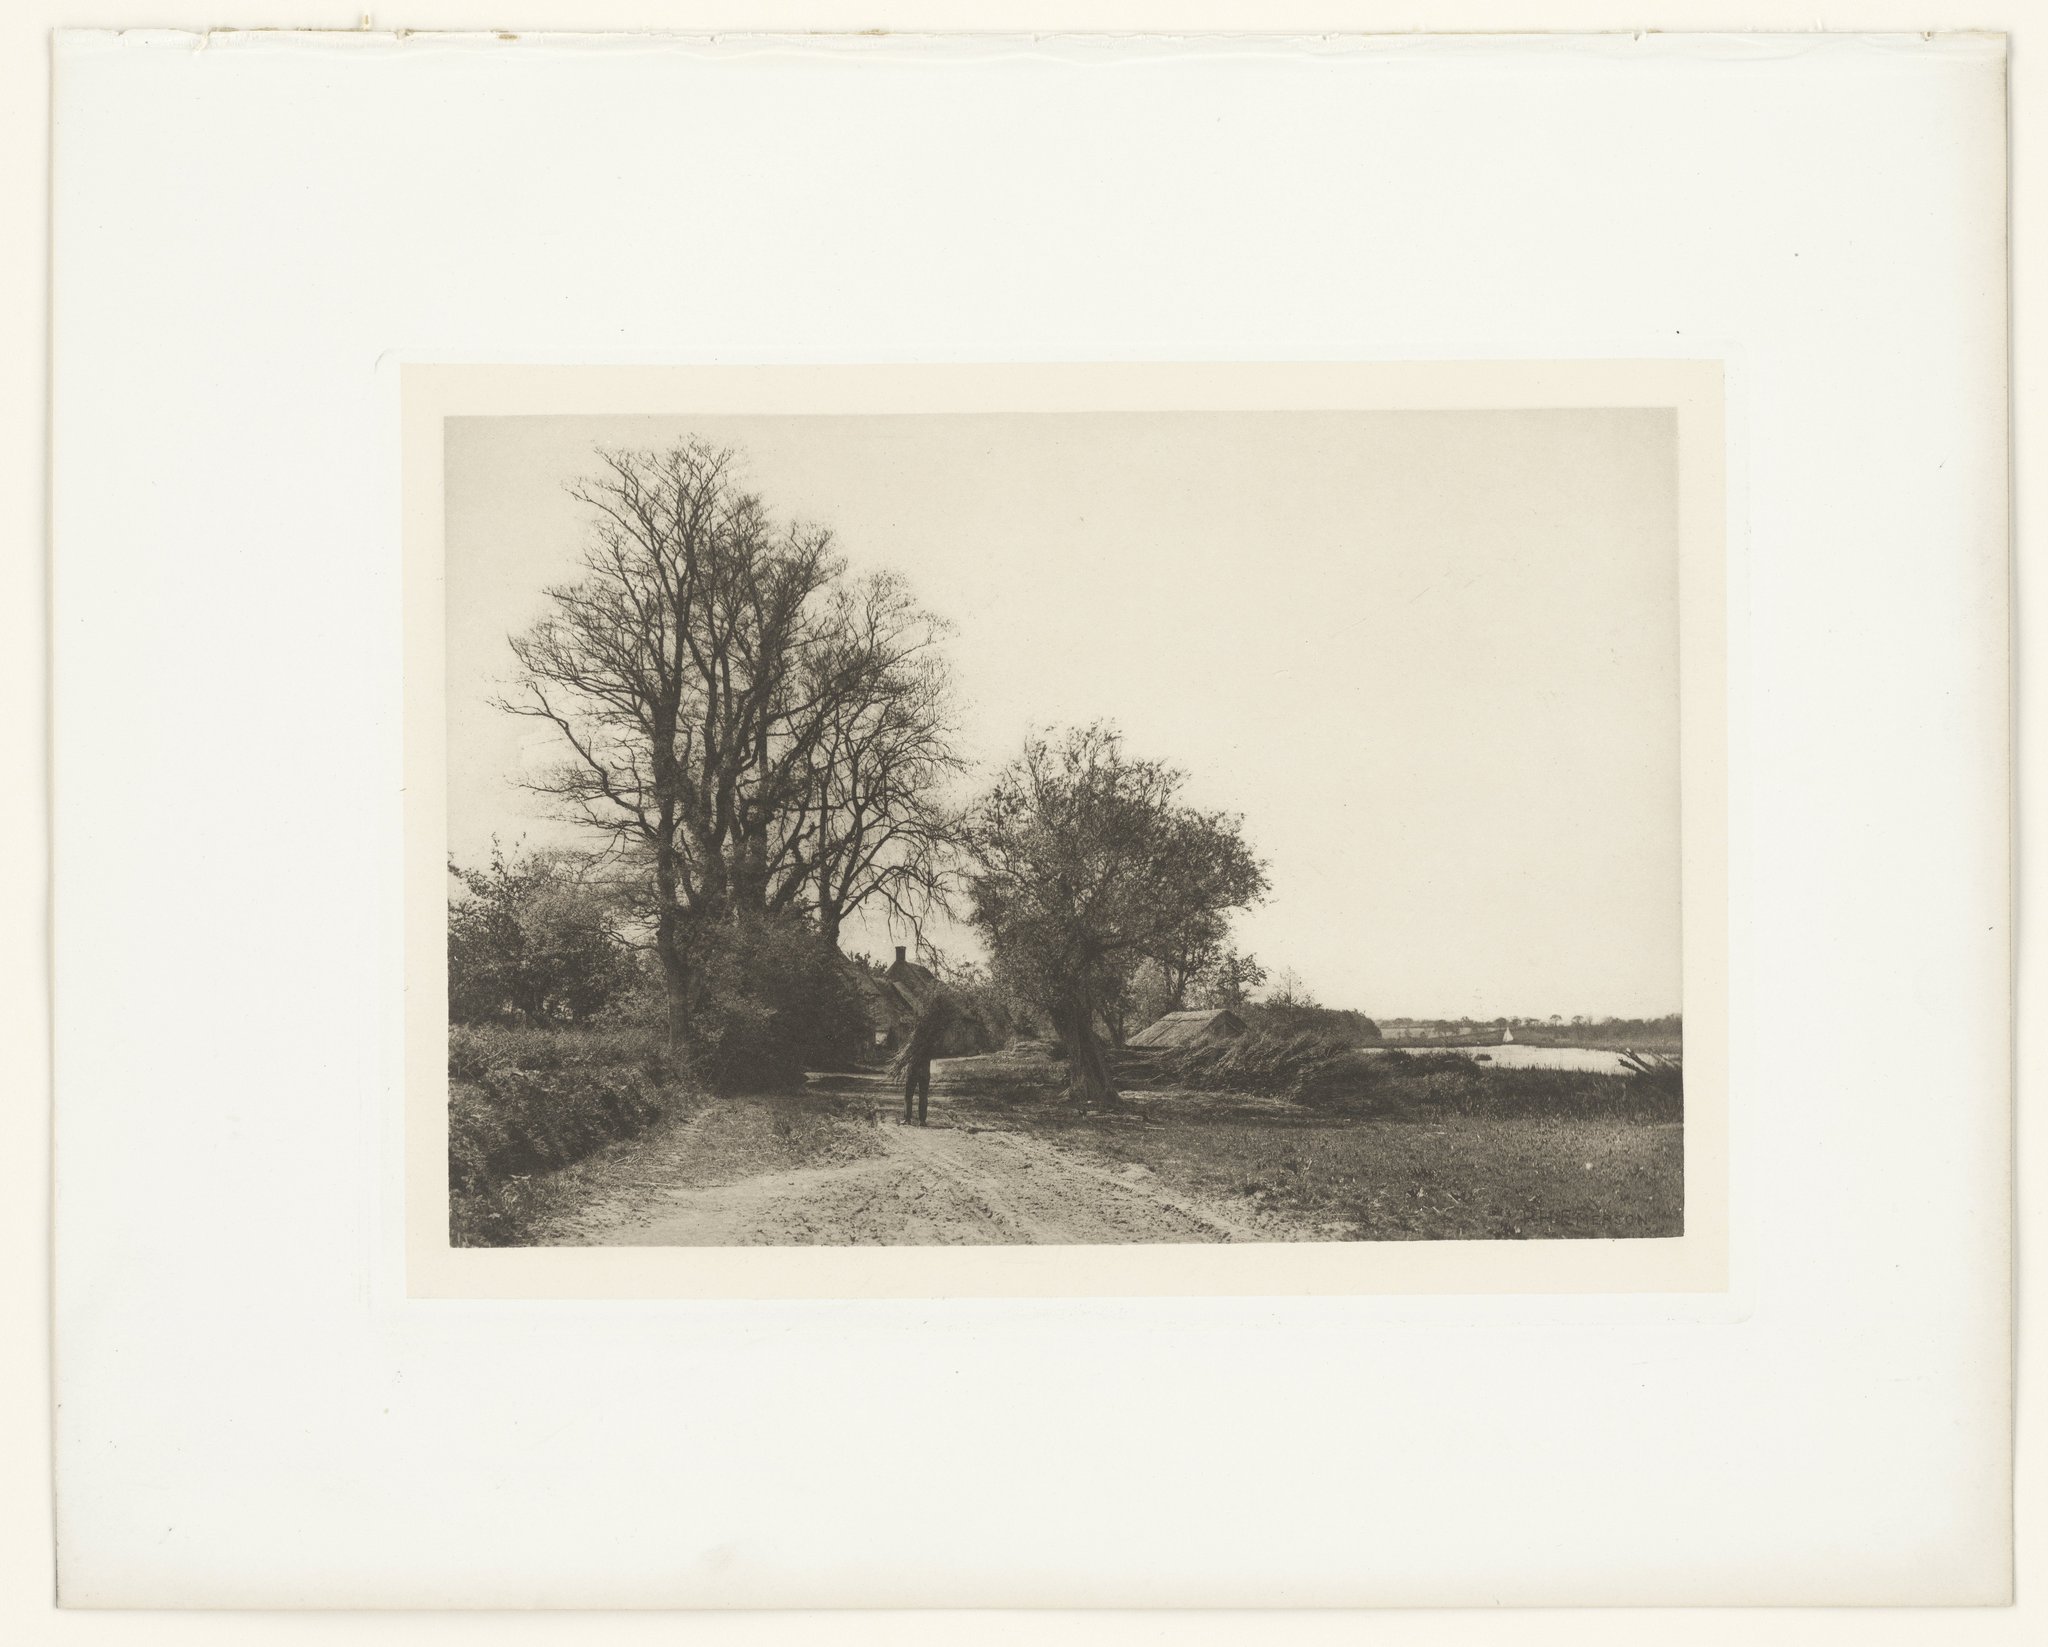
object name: photomechanical print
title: The Farm by the Broad (Norfolk)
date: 1883-1888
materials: cardboard, paper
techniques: photoaquatint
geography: norfolk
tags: farm or solitary house in landscape